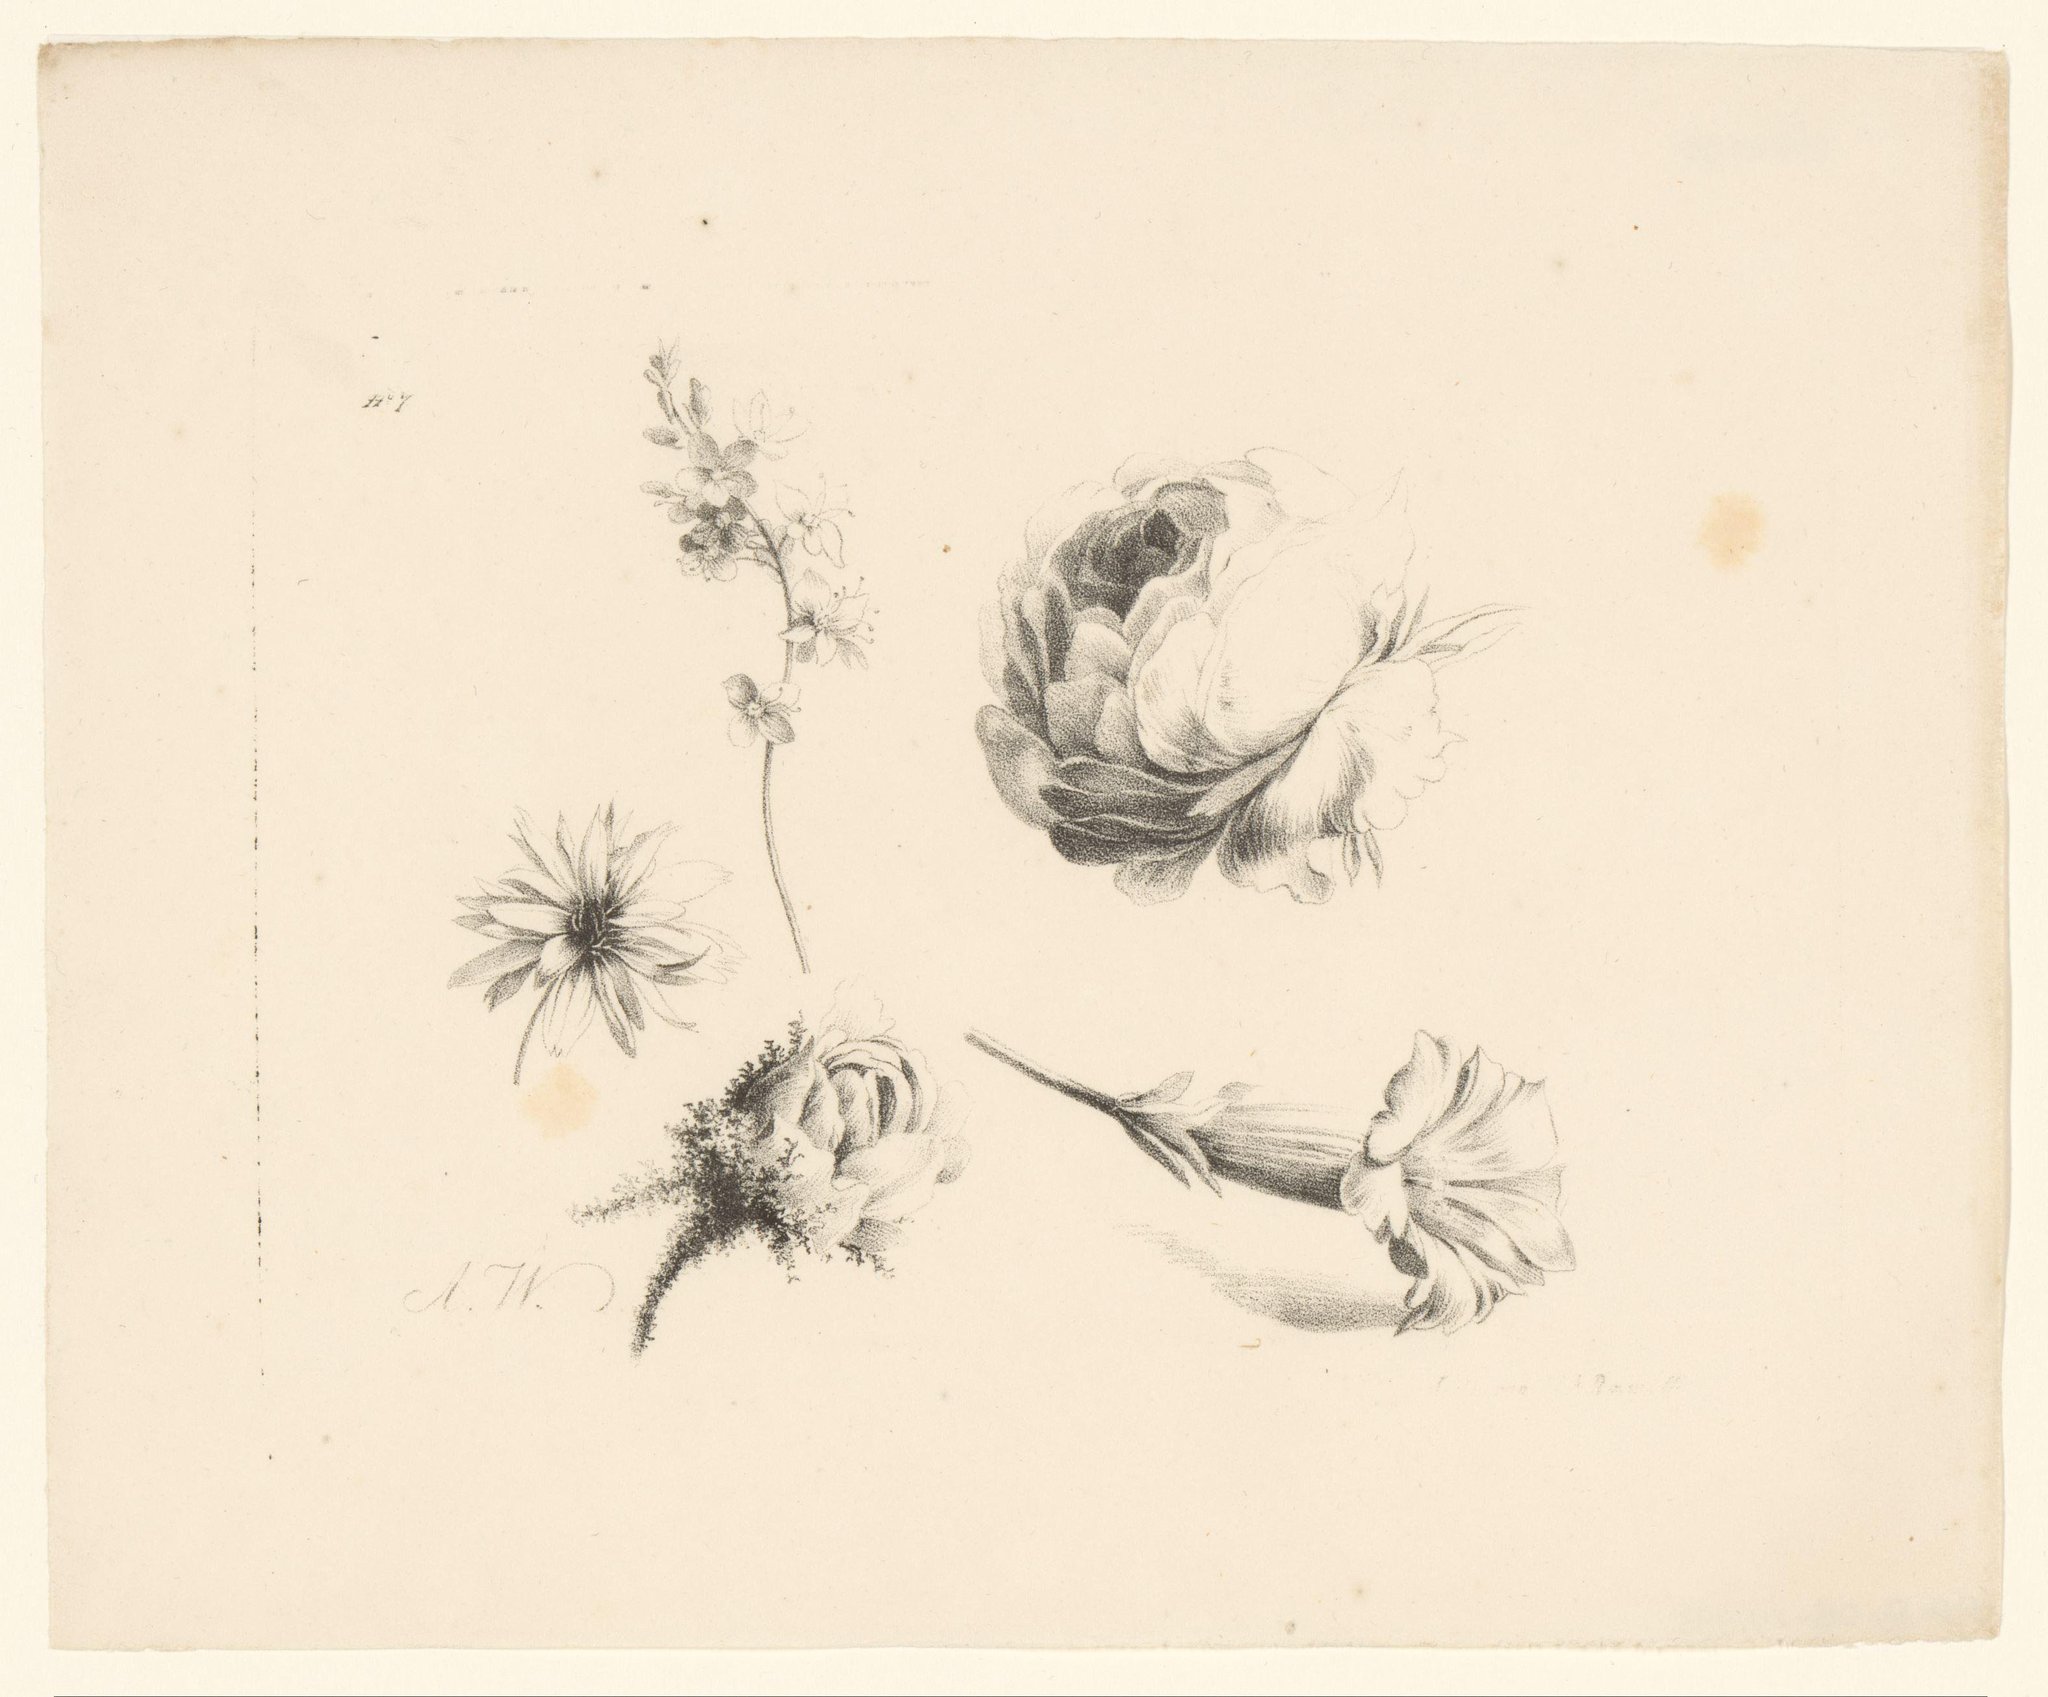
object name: print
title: Diverse bloemen waaronder twee rozen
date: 1820-1833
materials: paper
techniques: lithograph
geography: amsterdam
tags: flowers